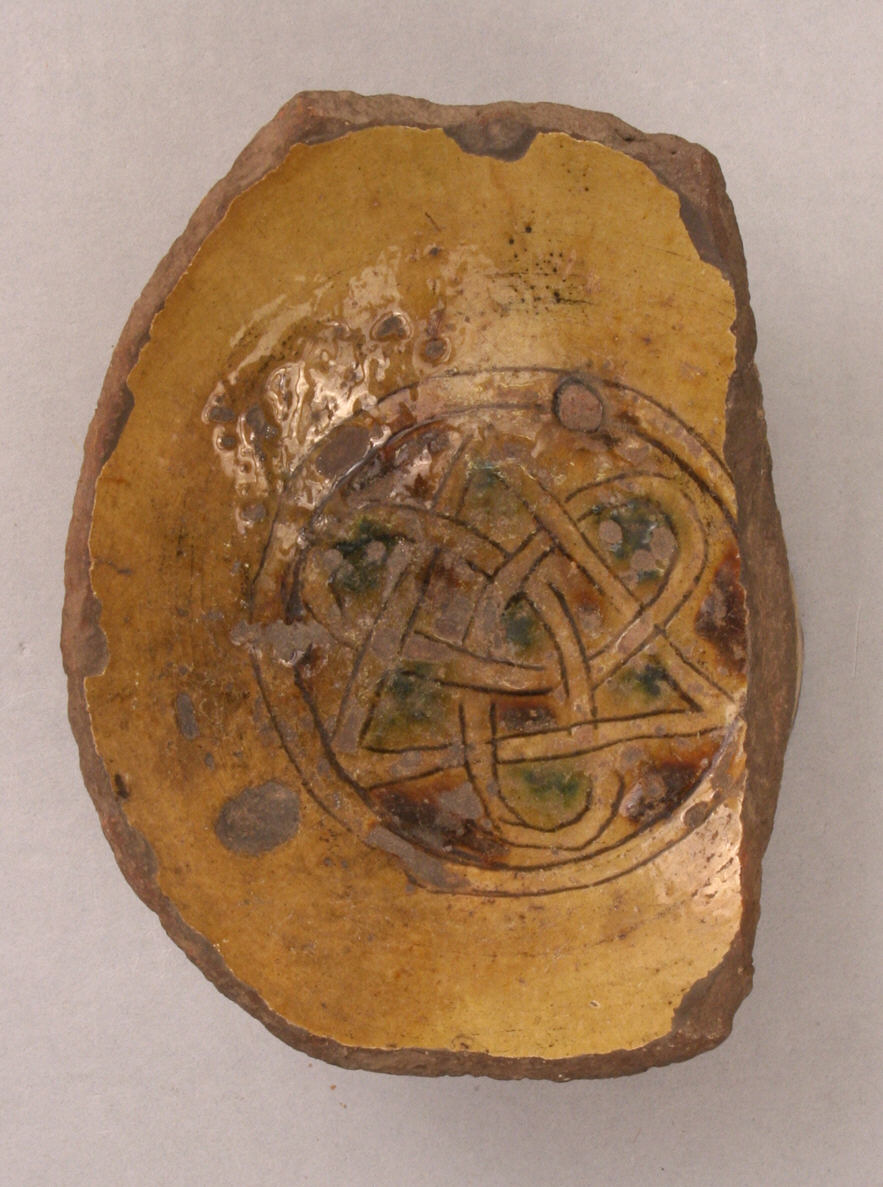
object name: fragment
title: Fragment of a Bowl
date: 1301-1500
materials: earthenware, glaze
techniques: coloring, incising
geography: egypt